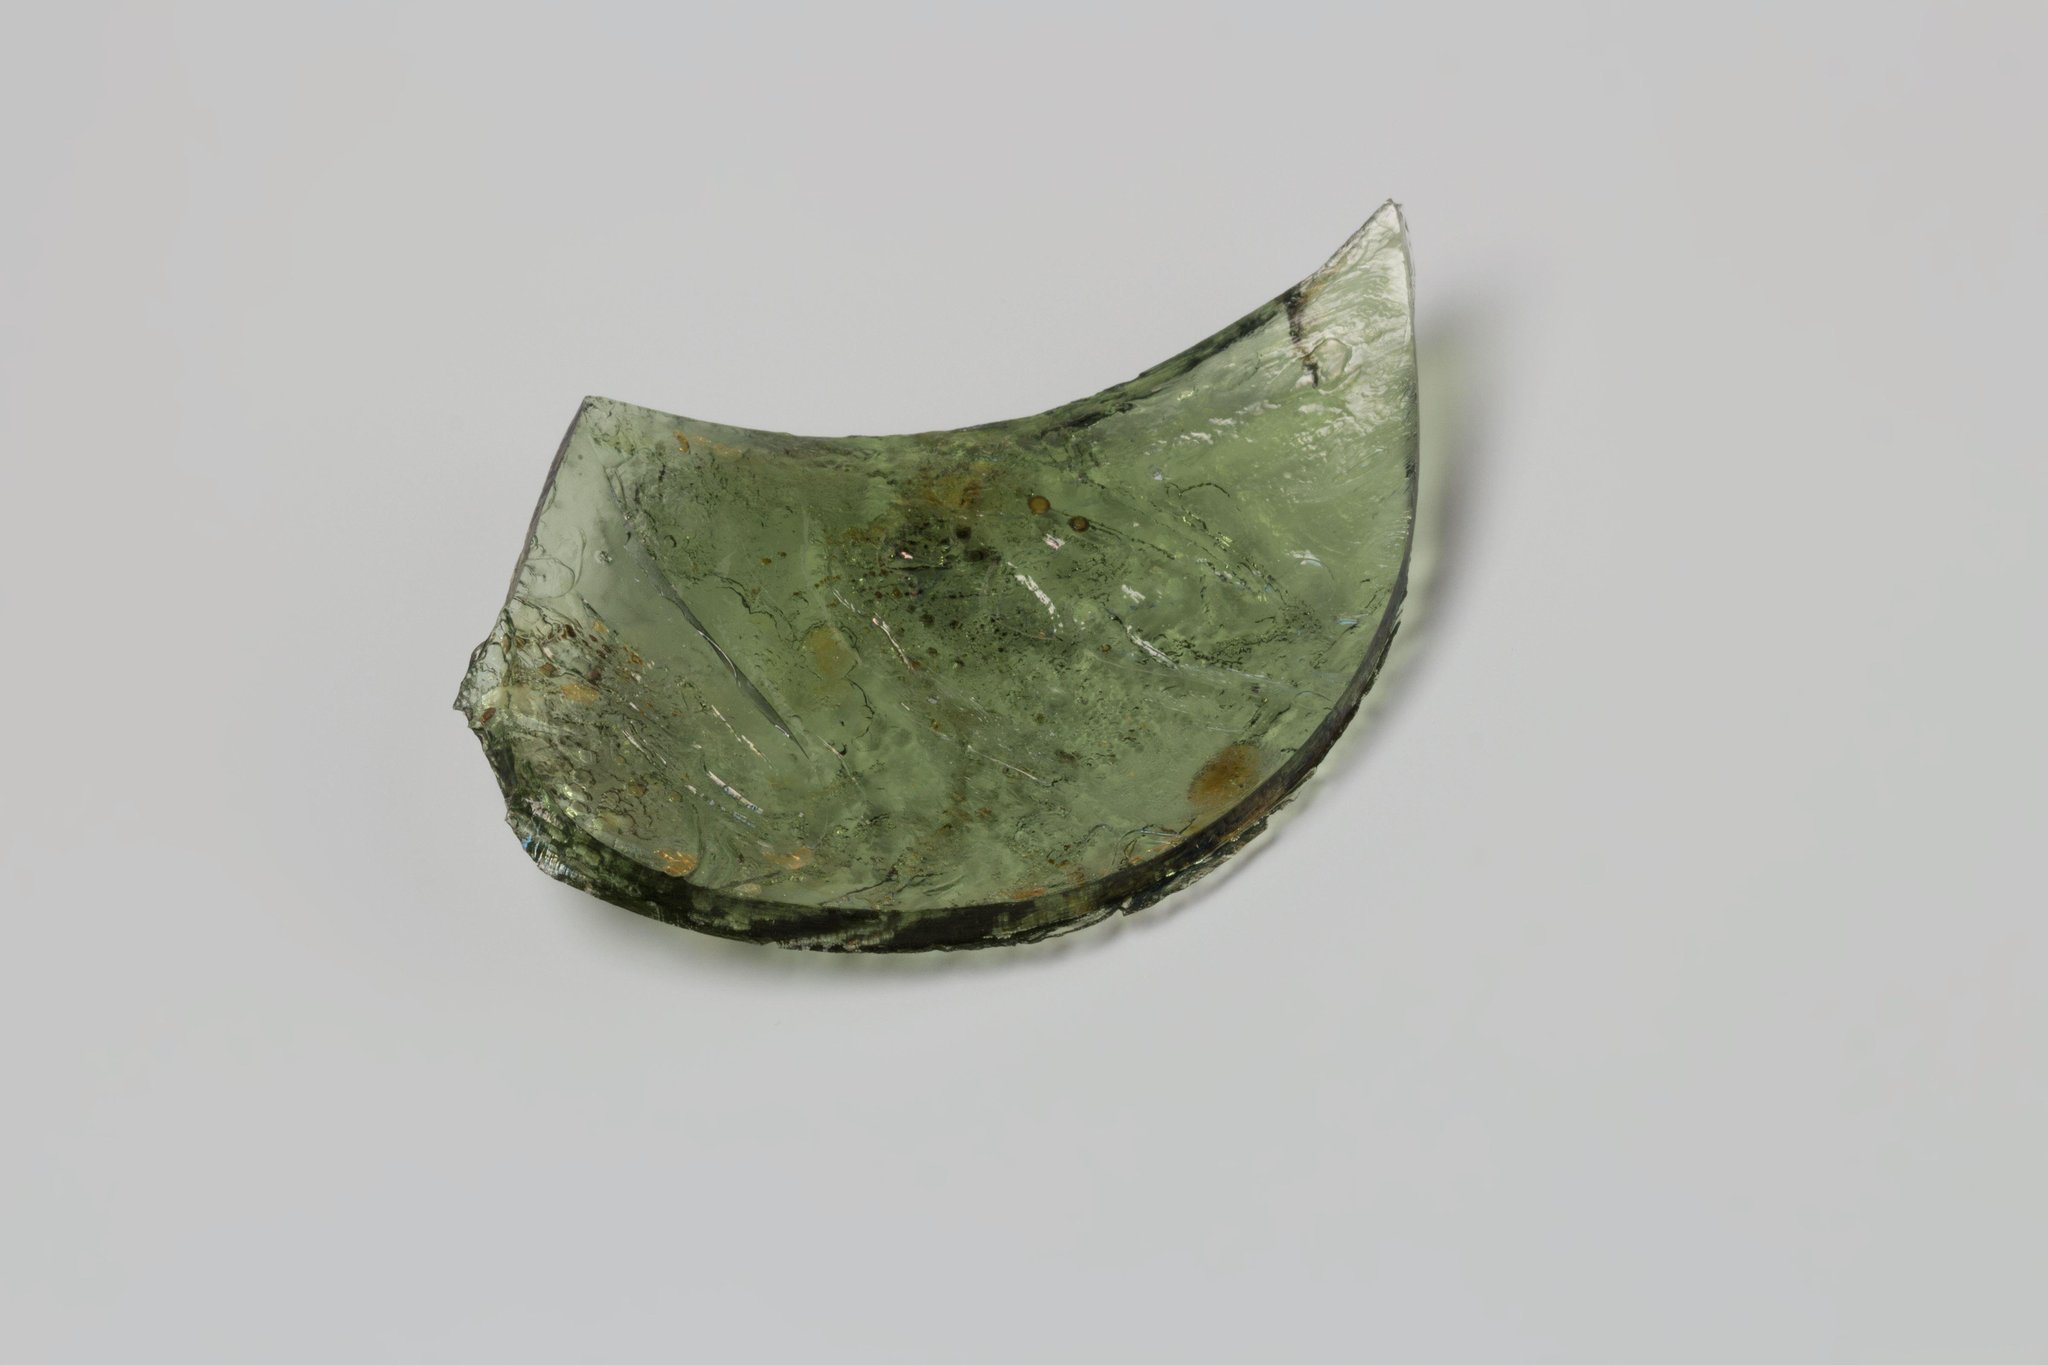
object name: sherd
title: Scherf van een wijnfles uit het wrak van de in 1735 vergane Oost-Indiëvaarder 't Vliegend Hart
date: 1700-1735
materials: glass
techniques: green glass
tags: 't vliegend hart (schip), verenigde oostindische compagnie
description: Groen glasfragment, deel van een wijnfles. Een zijde heeft een fijne structuur, de andere is ruwer.